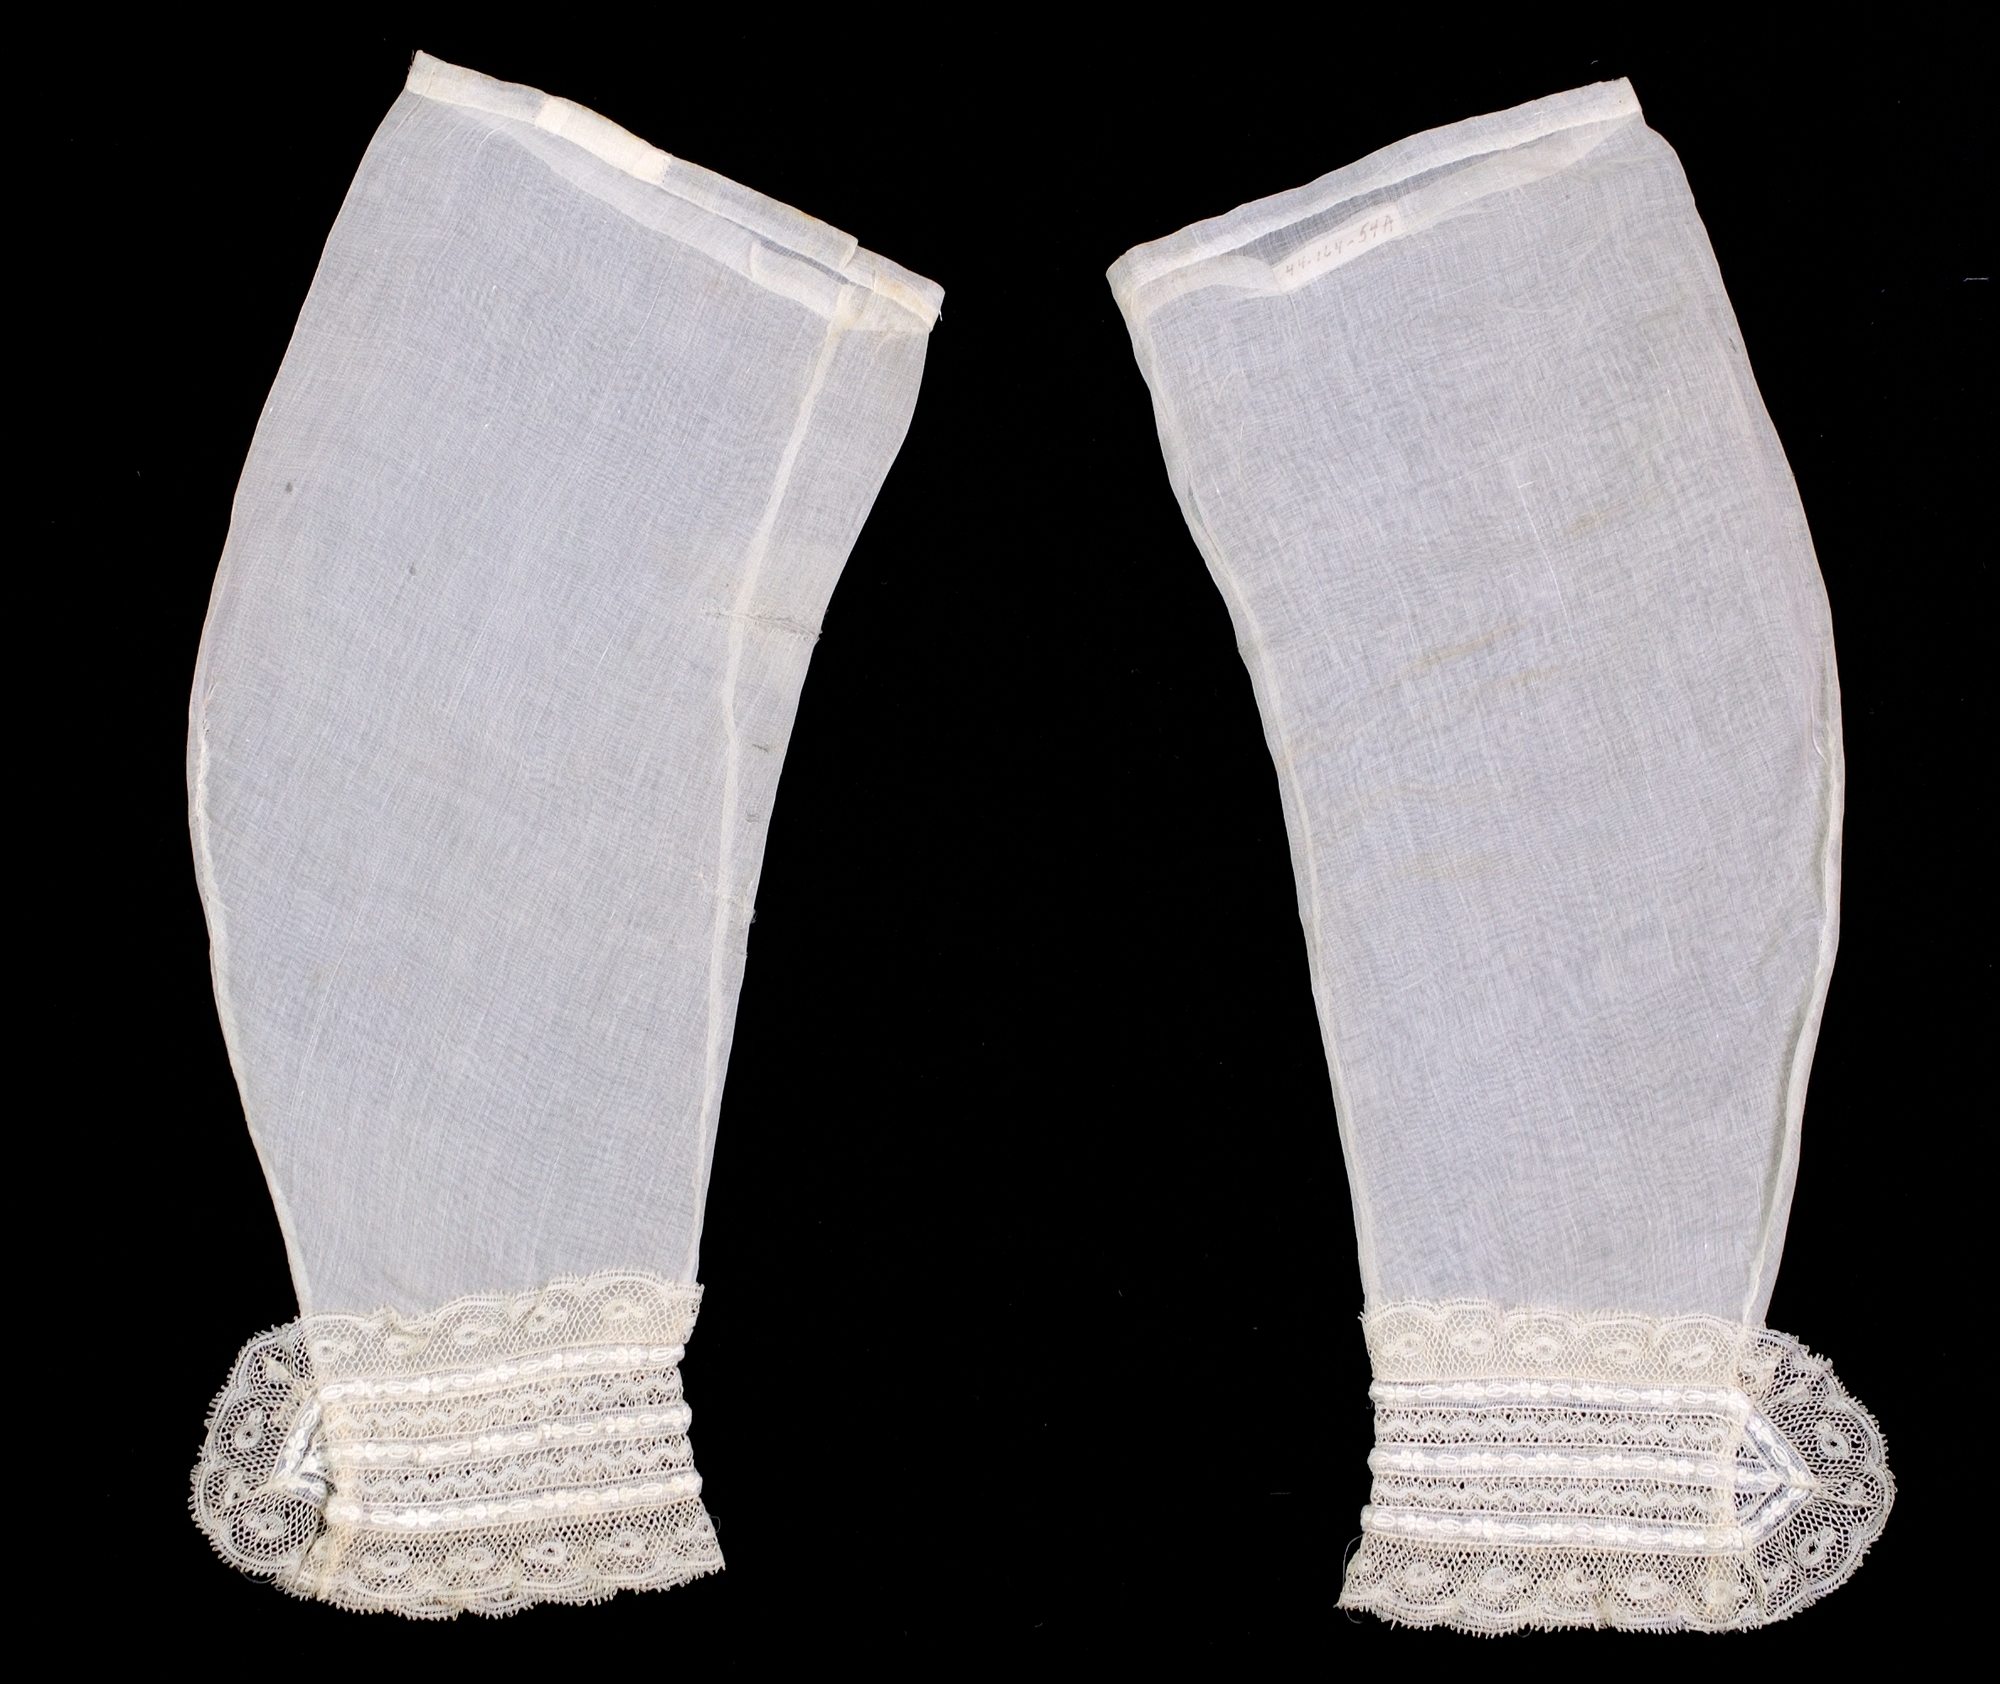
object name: undersleeves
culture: american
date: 1850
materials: cotton